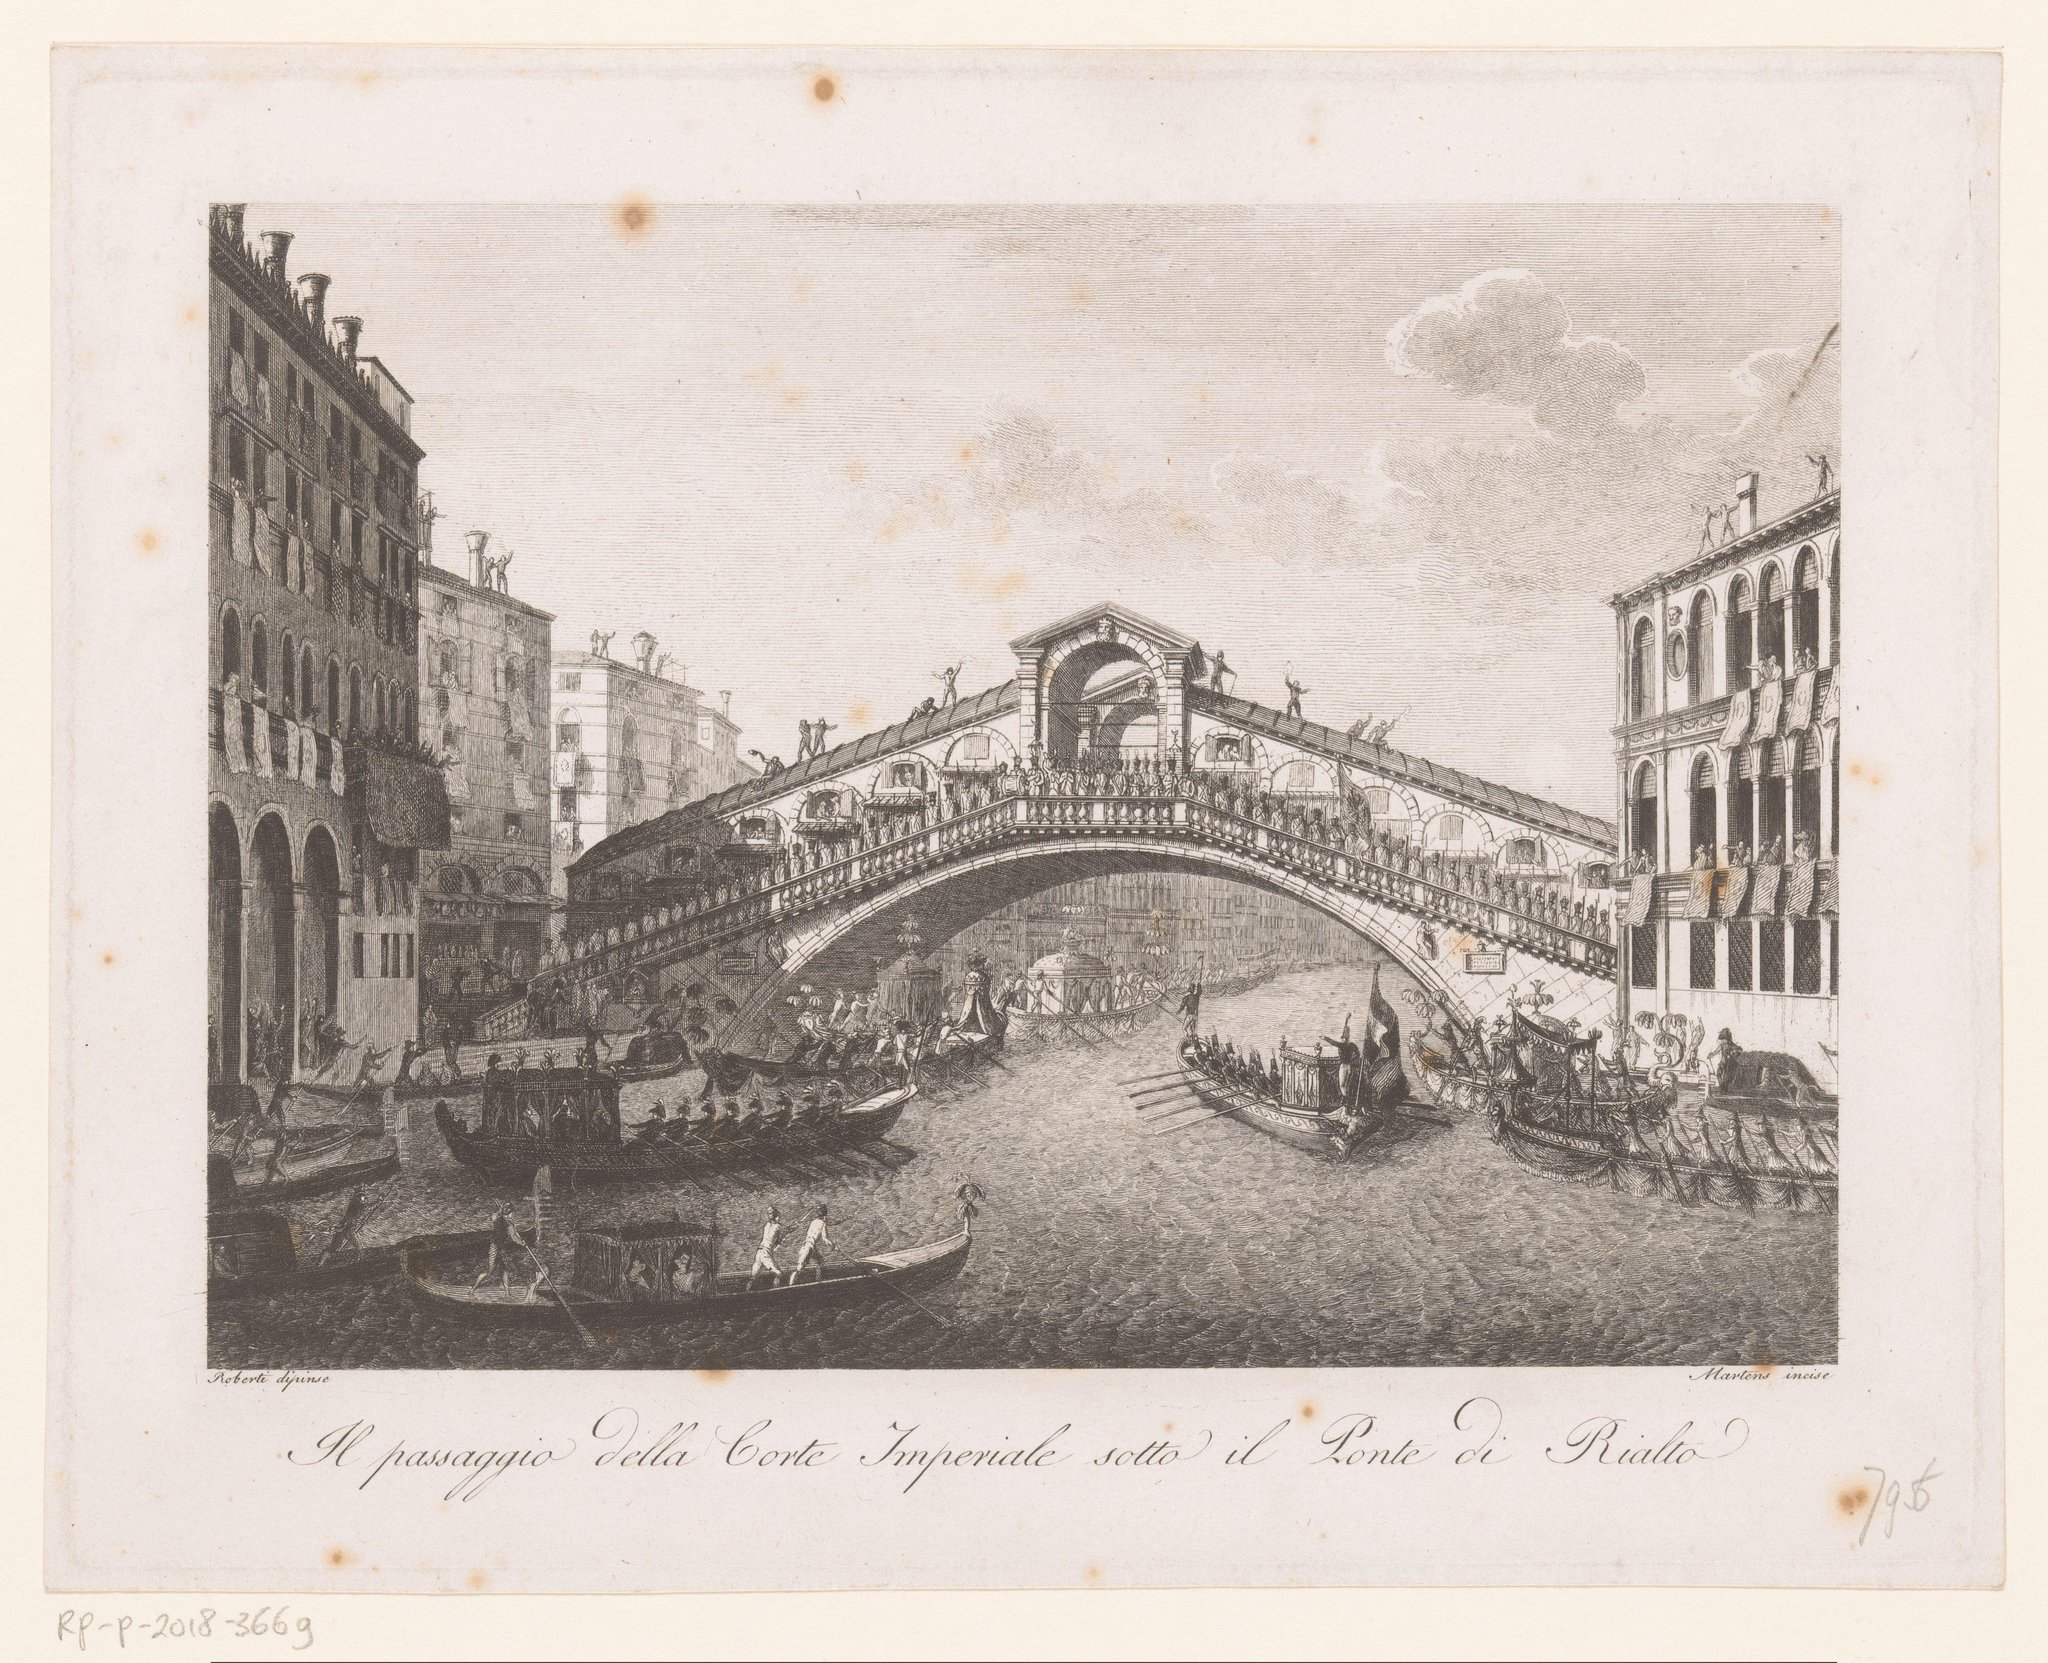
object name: print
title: Il passagio della Corte Imperiale sotto il Ponte di Rialto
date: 1816-1837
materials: paper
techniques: engraving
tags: canals, waters (in city), bridge in city across river, canal, etc., gondola